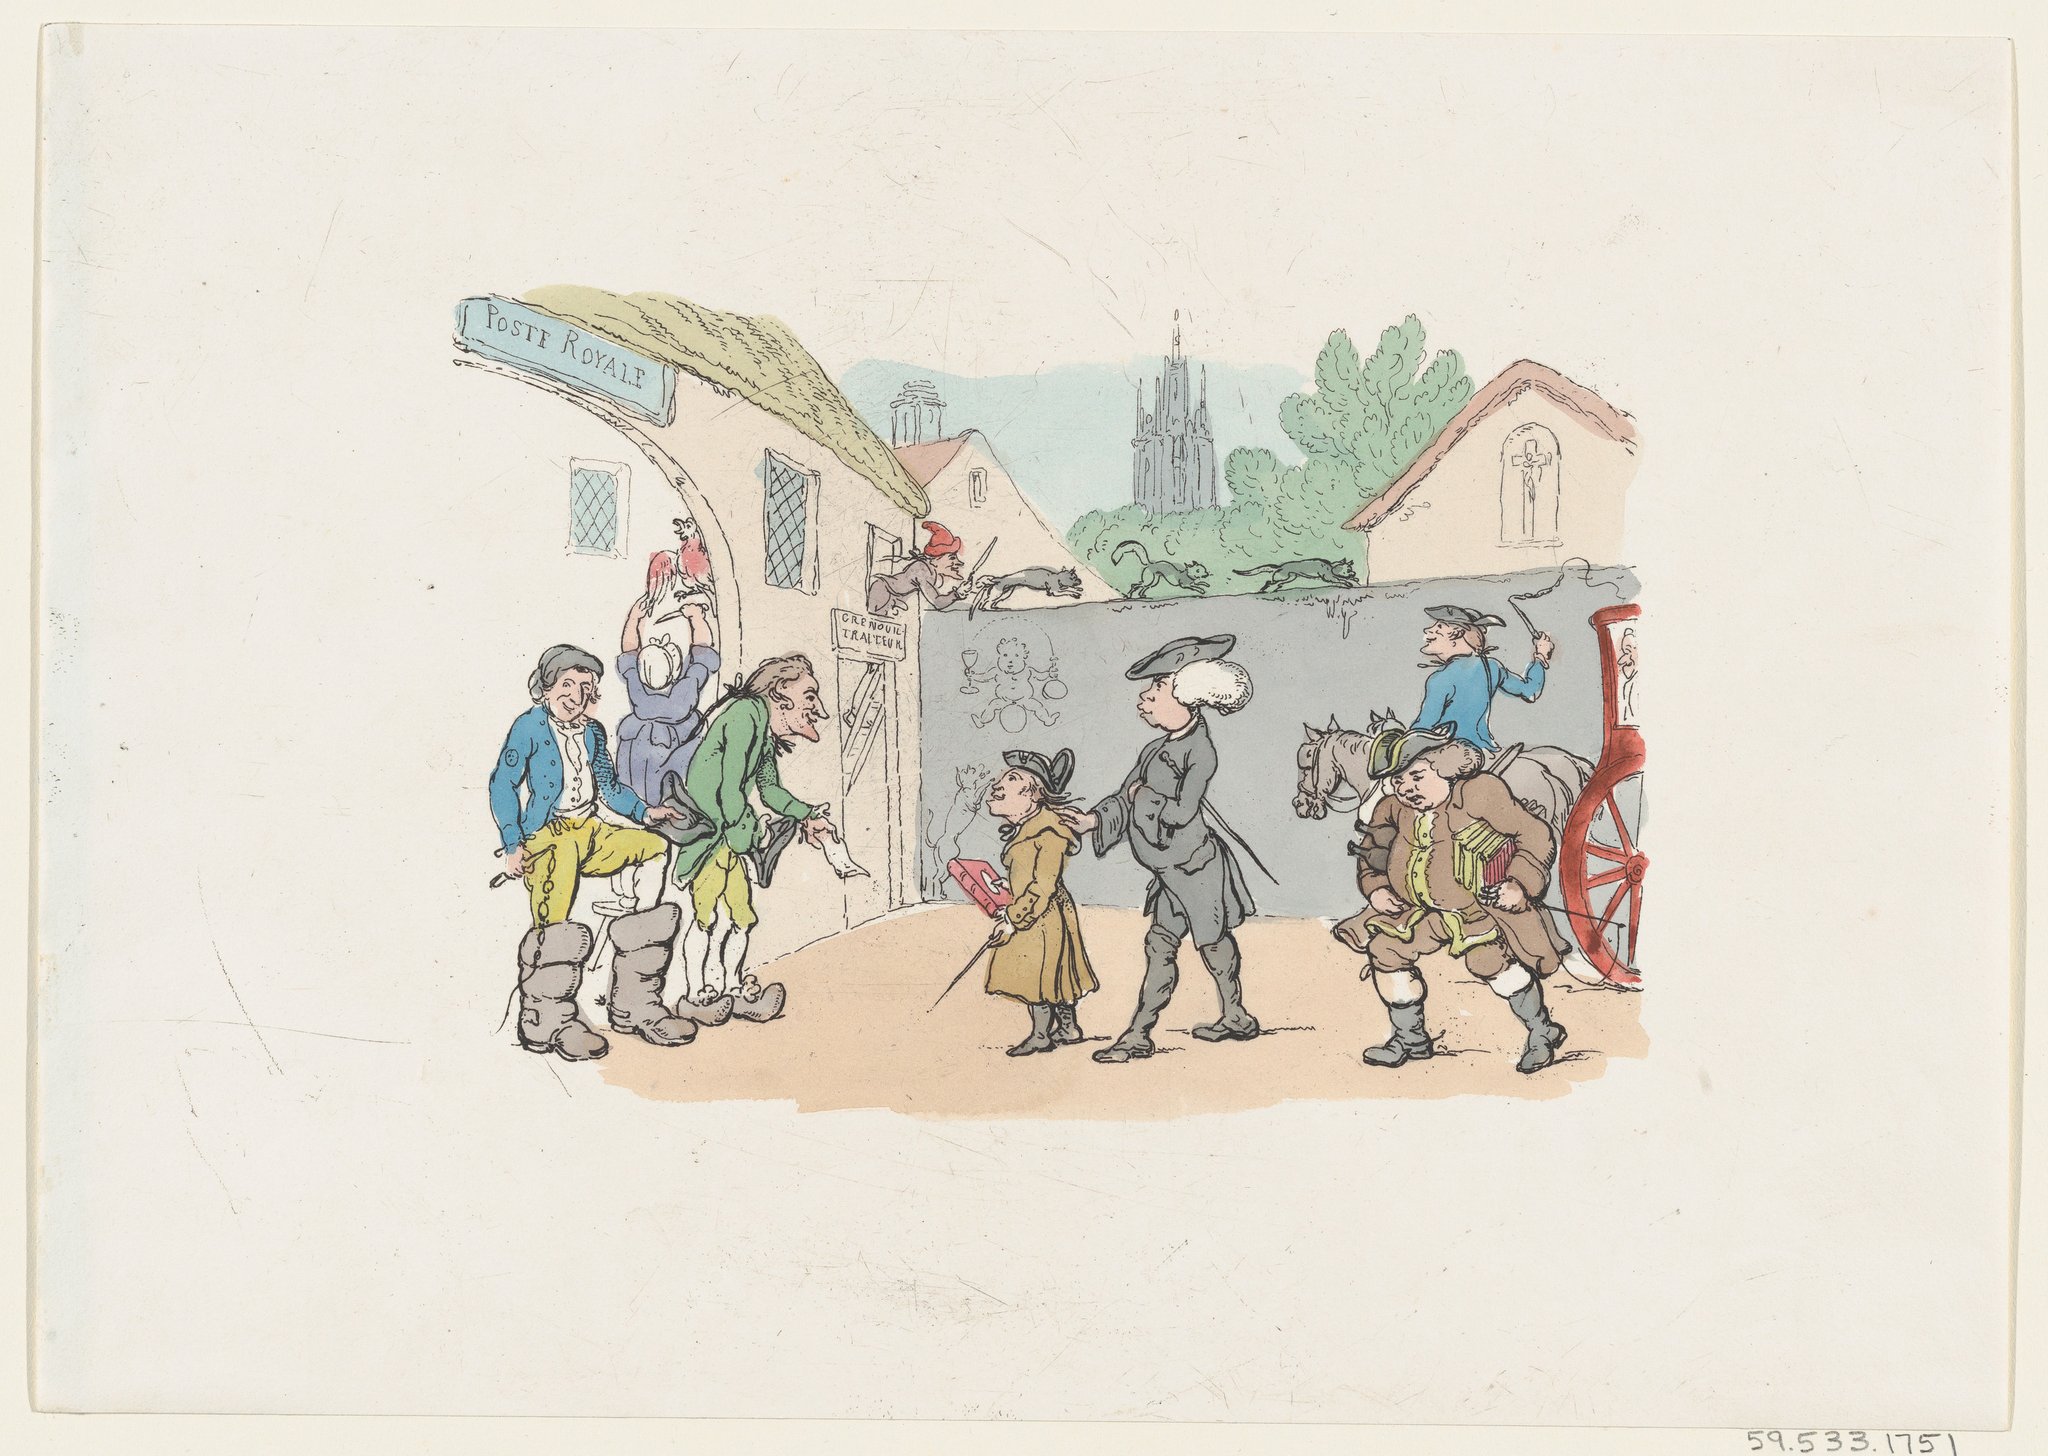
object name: print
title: A Tour to Foreign Parts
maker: thomas rowlandson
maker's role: artist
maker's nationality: british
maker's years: 1757-1827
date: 1807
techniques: etching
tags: satire,men,horses